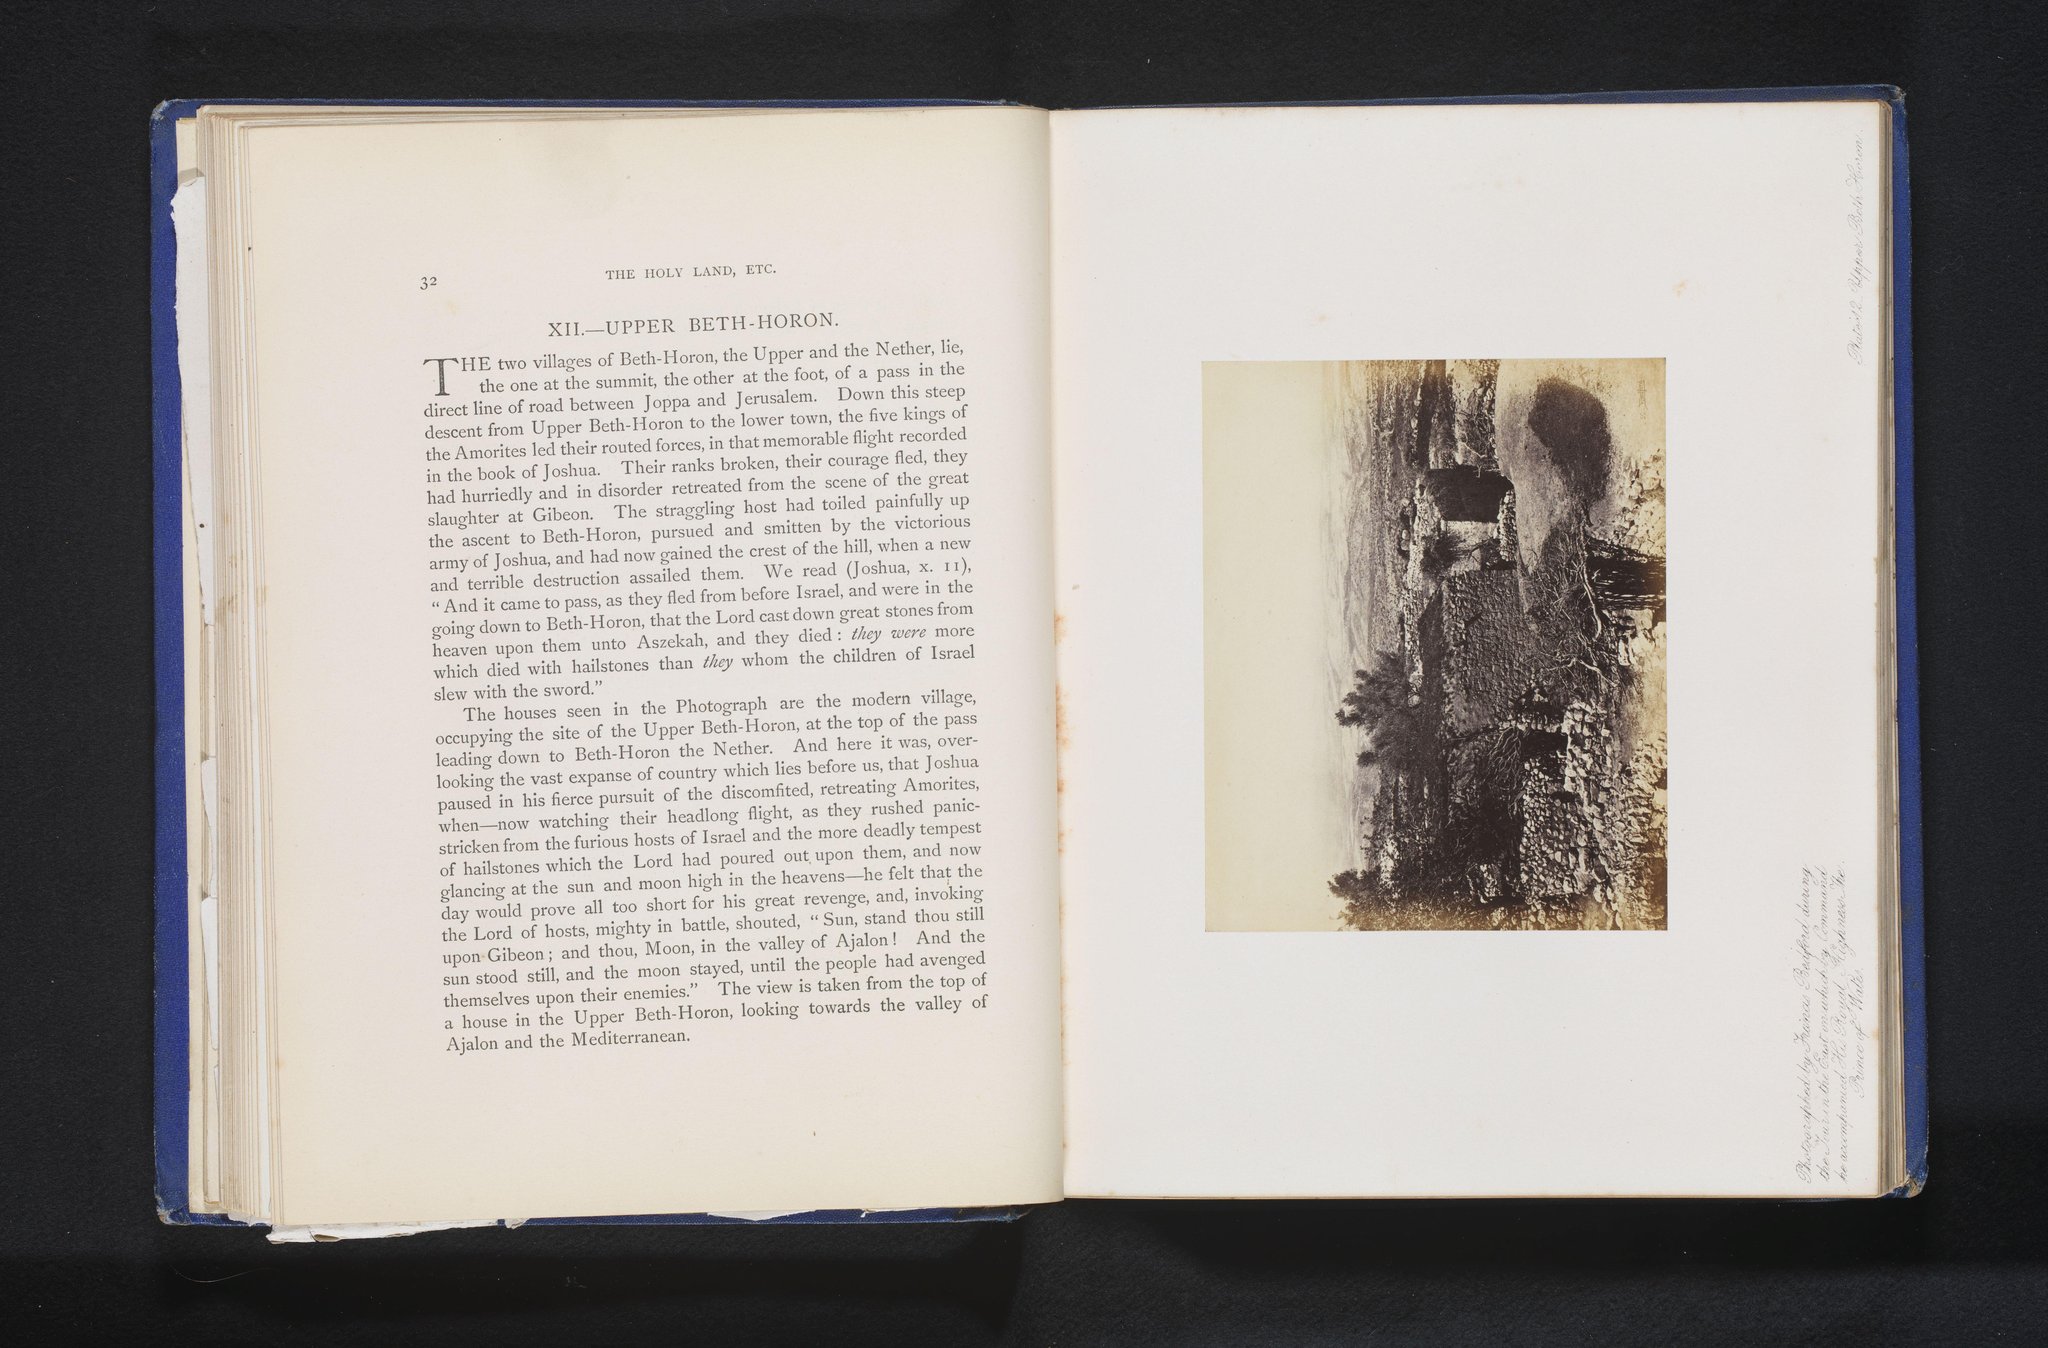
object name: photograph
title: Upper Beth-Horon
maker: francis bedford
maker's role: print maker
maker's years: 1815-1894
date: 1861-1866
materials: photographic support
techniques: albumen print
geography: palestine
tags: city-view in general; 'veduta'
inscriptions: number: ‘Plate 12.’, inscription: ‘Photographed by Francis Bedford during the Tour in the East on which by Command he accompanied His Royal Highness The Prince of Wales’